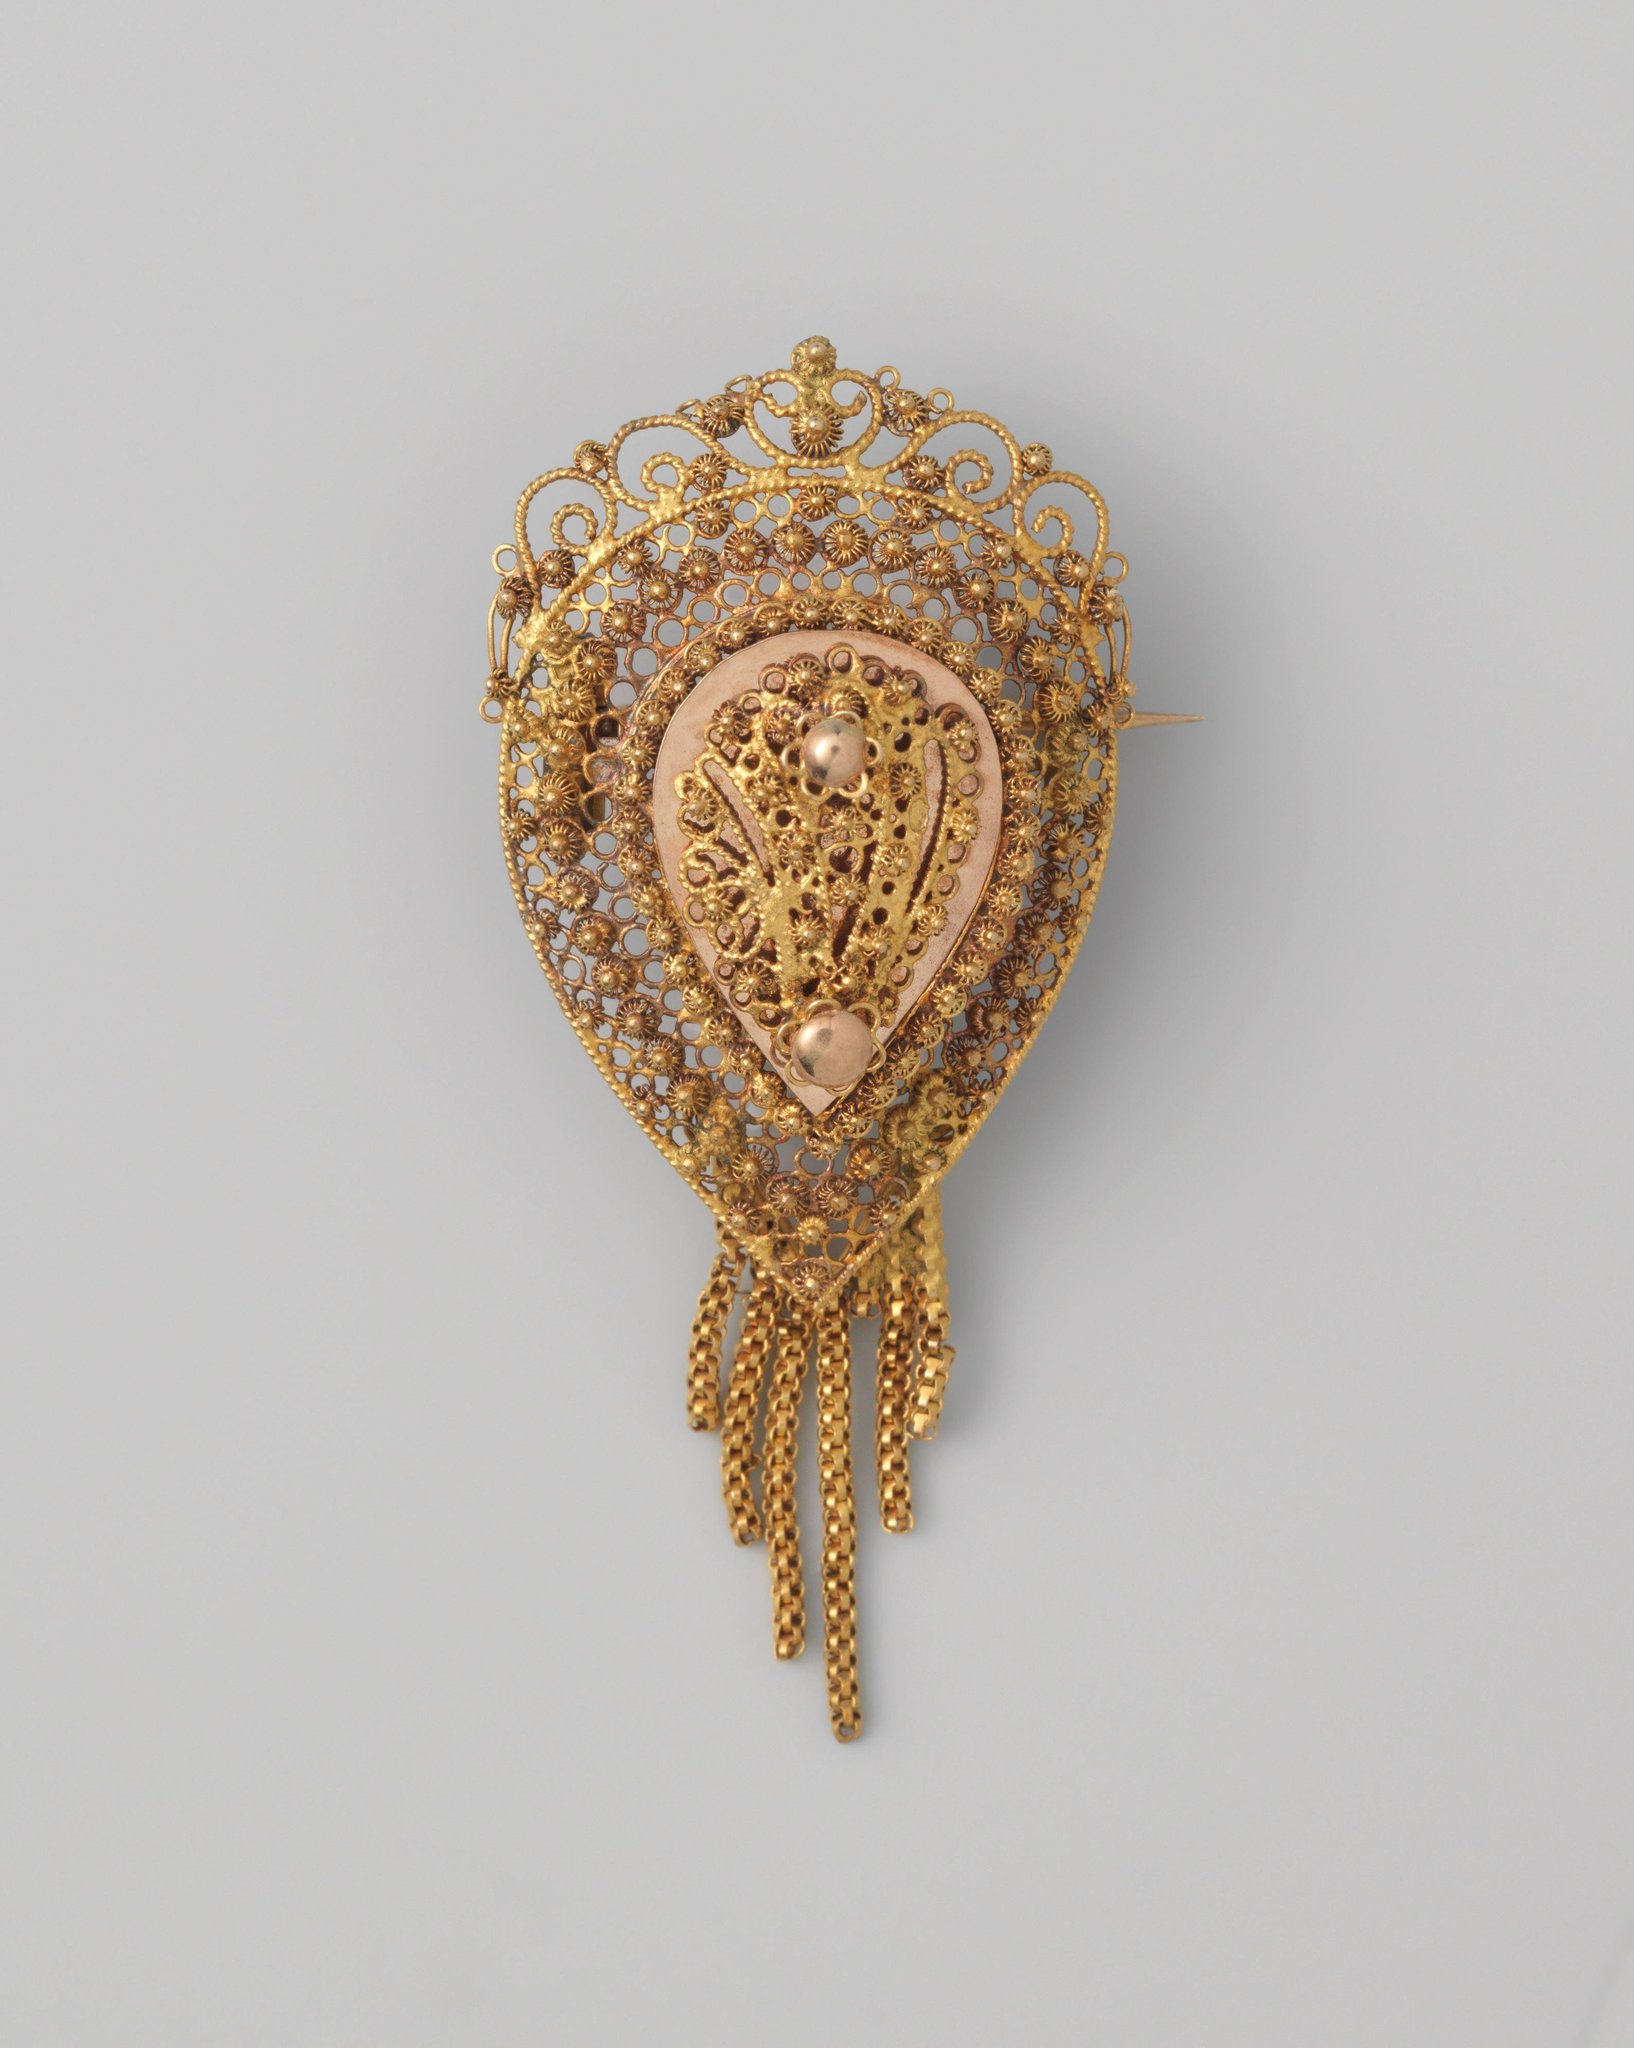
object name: brooch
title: Broche van goud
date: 1860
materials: gold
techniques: filigree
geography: netherlands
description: Broche van goud. De omgekeerd druppelvormige broche heeft een verhoogd middengedeelte met een ornament van filigrein op een gladde ondergrond. De brede rand bestaat geheel uit opengewerkt filigrein. Aan de onderkant een franje van 7 kettinkjes. Gemerkt: eikeblaadje.